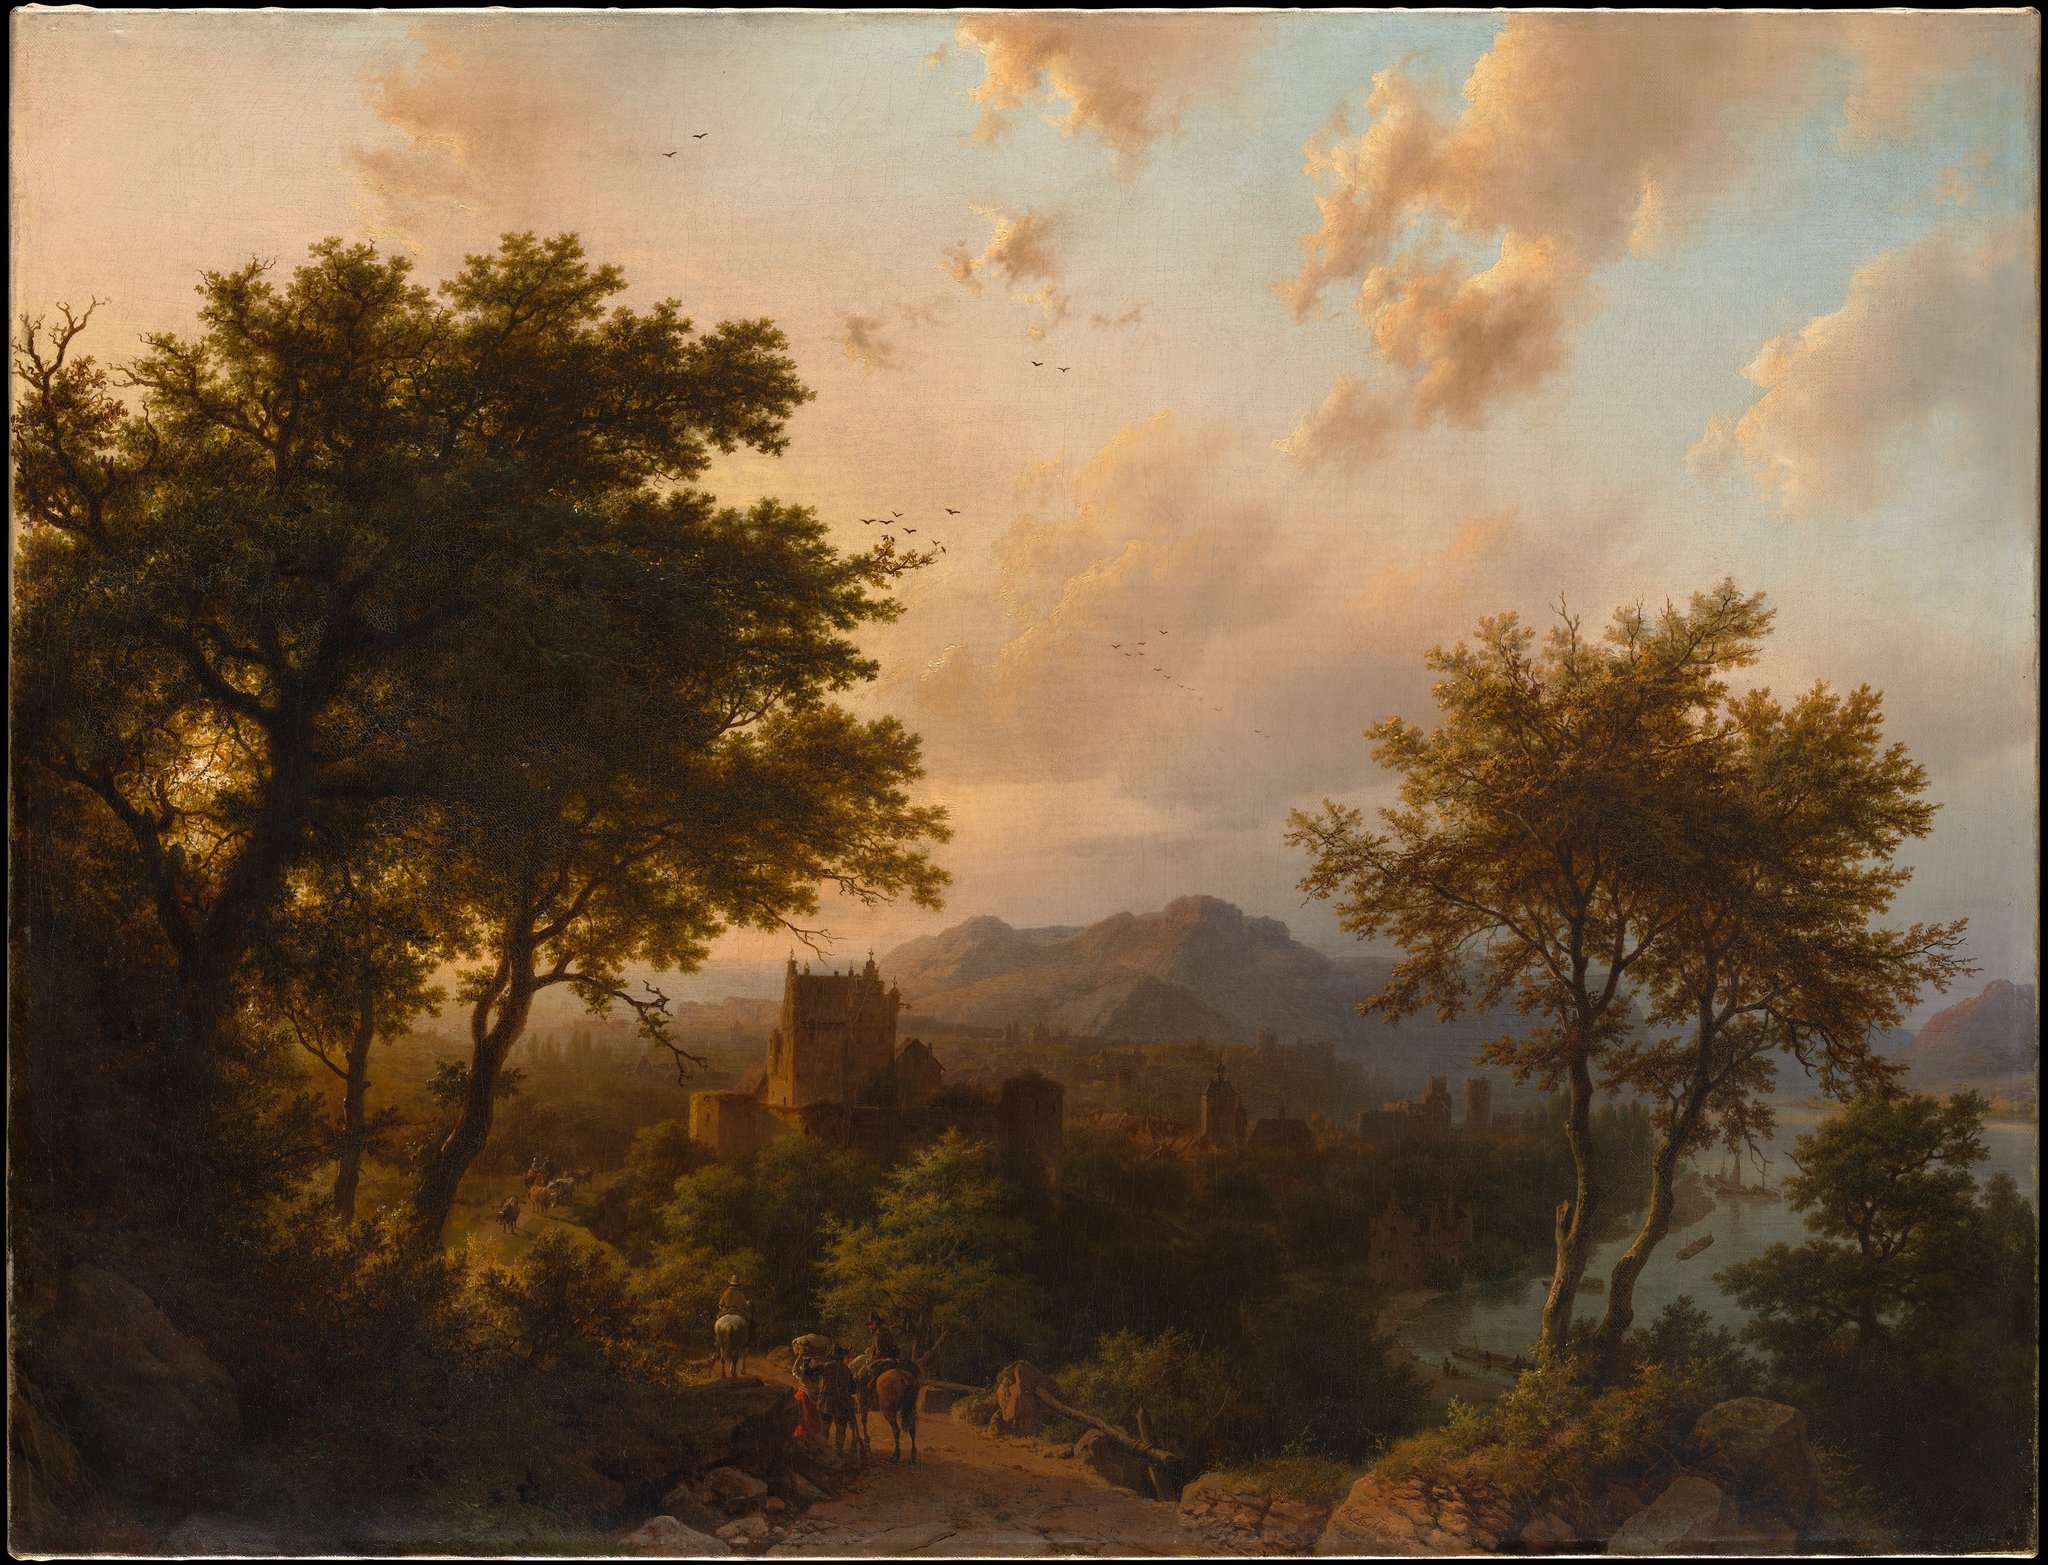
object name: painting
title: Sunset on the Rhine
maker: barend cornelis koekkoek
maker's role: artist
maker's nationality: dutch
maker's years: 1803-1862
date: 1853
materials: canvas, oil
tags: rivers,landscapes,evening